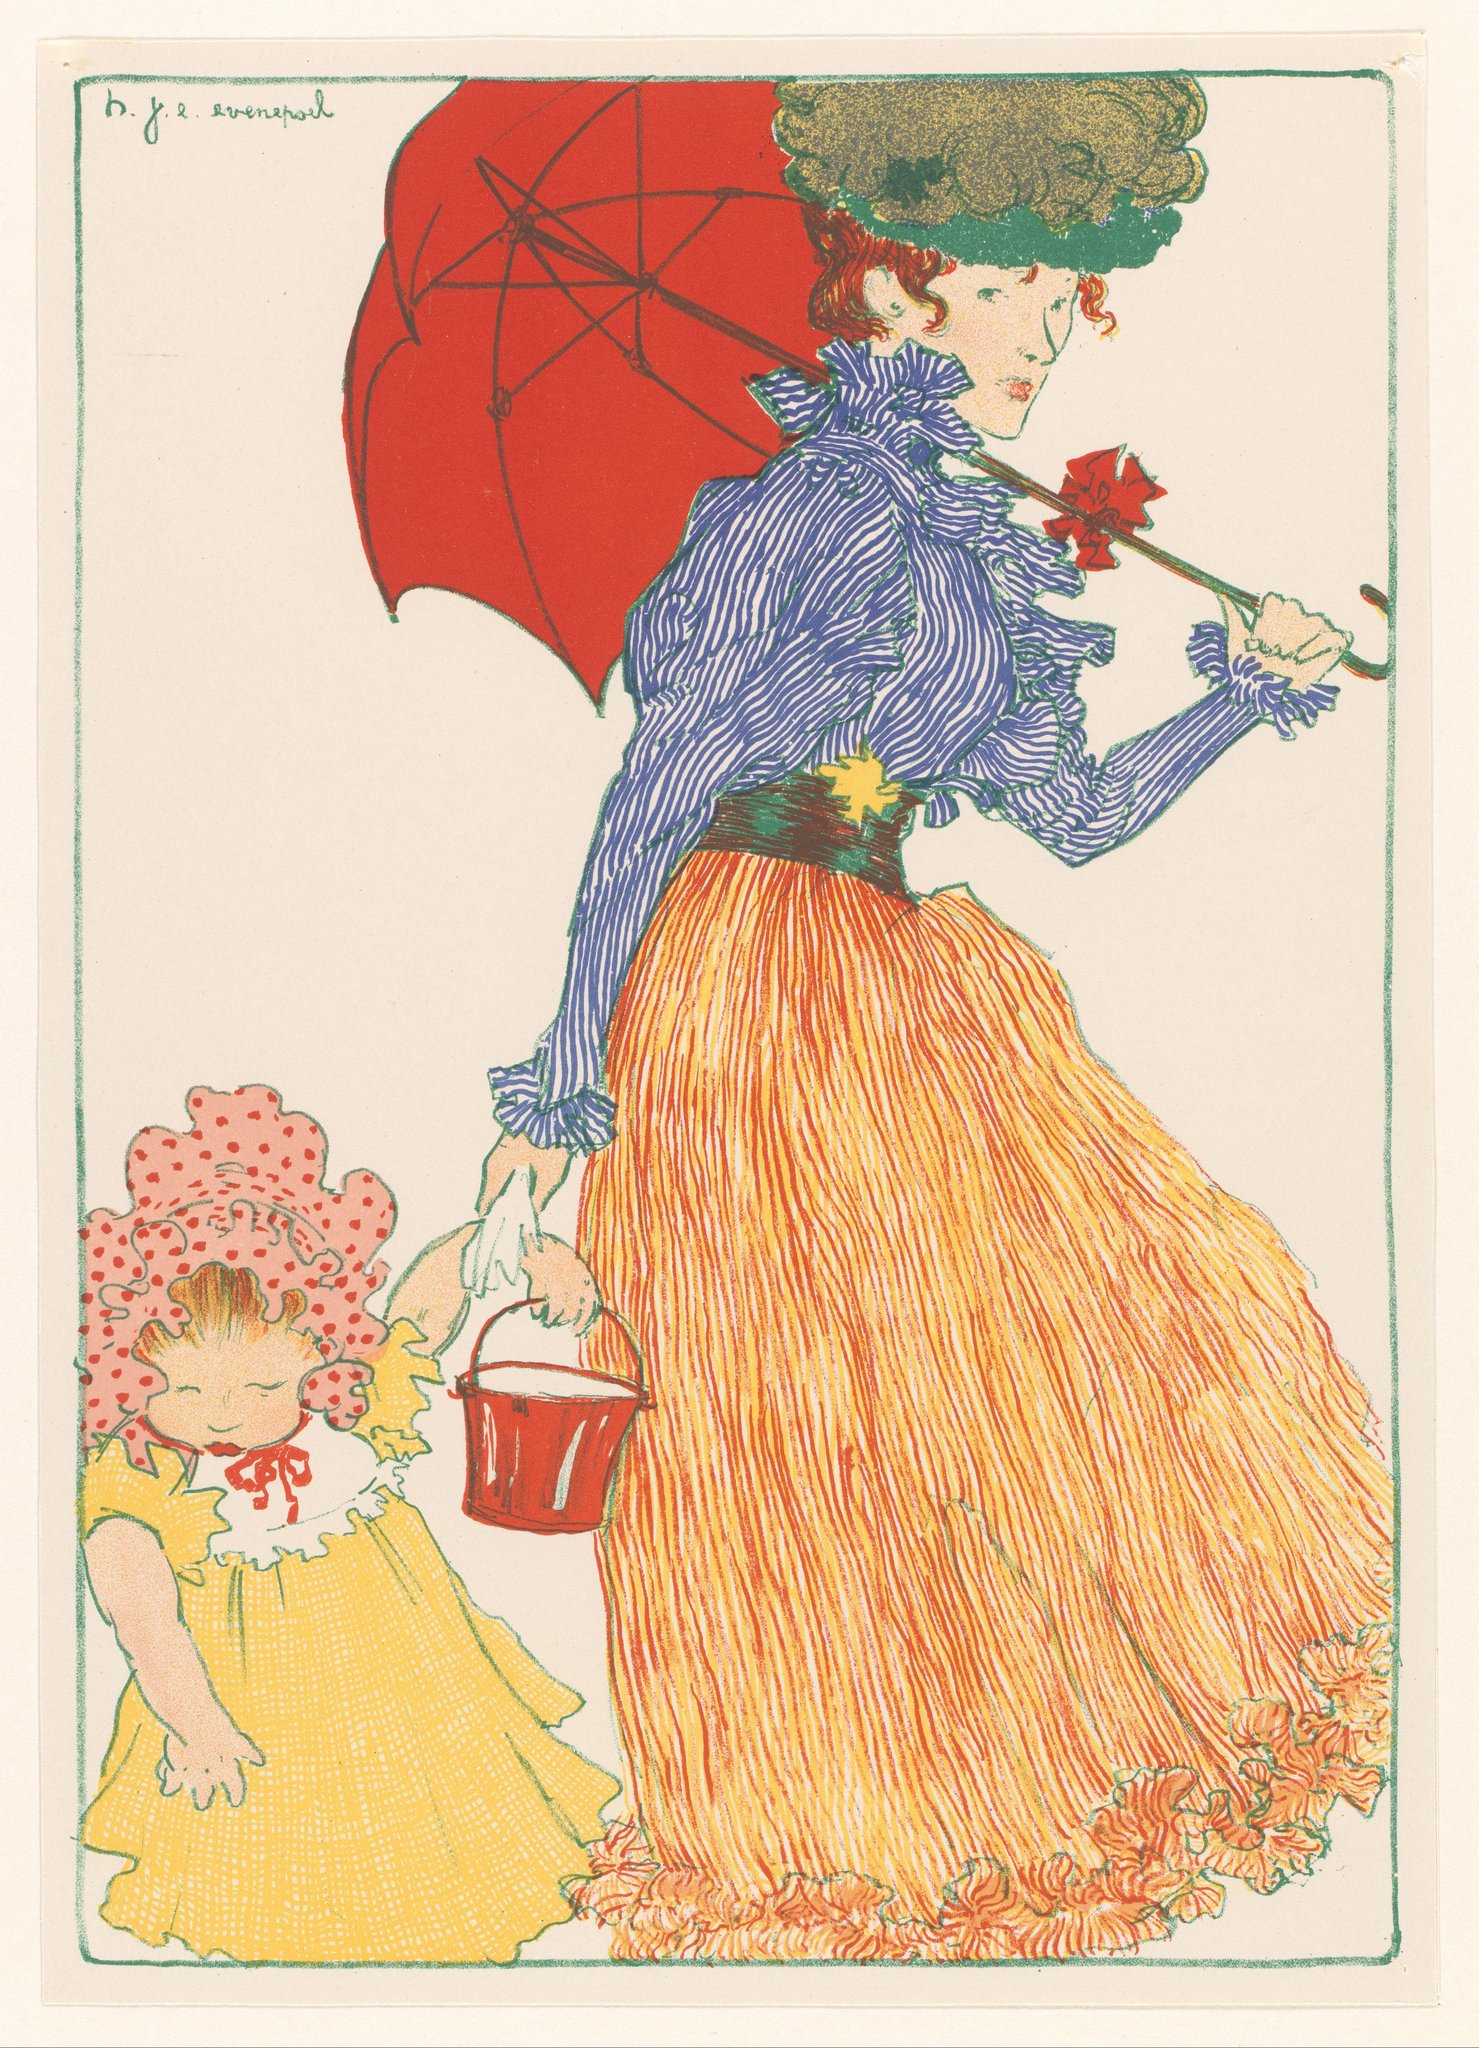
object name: print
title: Vrouw met rode paraplu houdt een meisje vast aan haar arm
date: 1897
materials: paper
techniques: lithograph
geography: paris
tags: carrying something in basket, bag, rucksack, etc., mother and baby or young child, umbrella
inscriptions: collector's mark: Lugt 2228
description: Prent mogelijk uit: L'Estampe moderne 7 (1897).